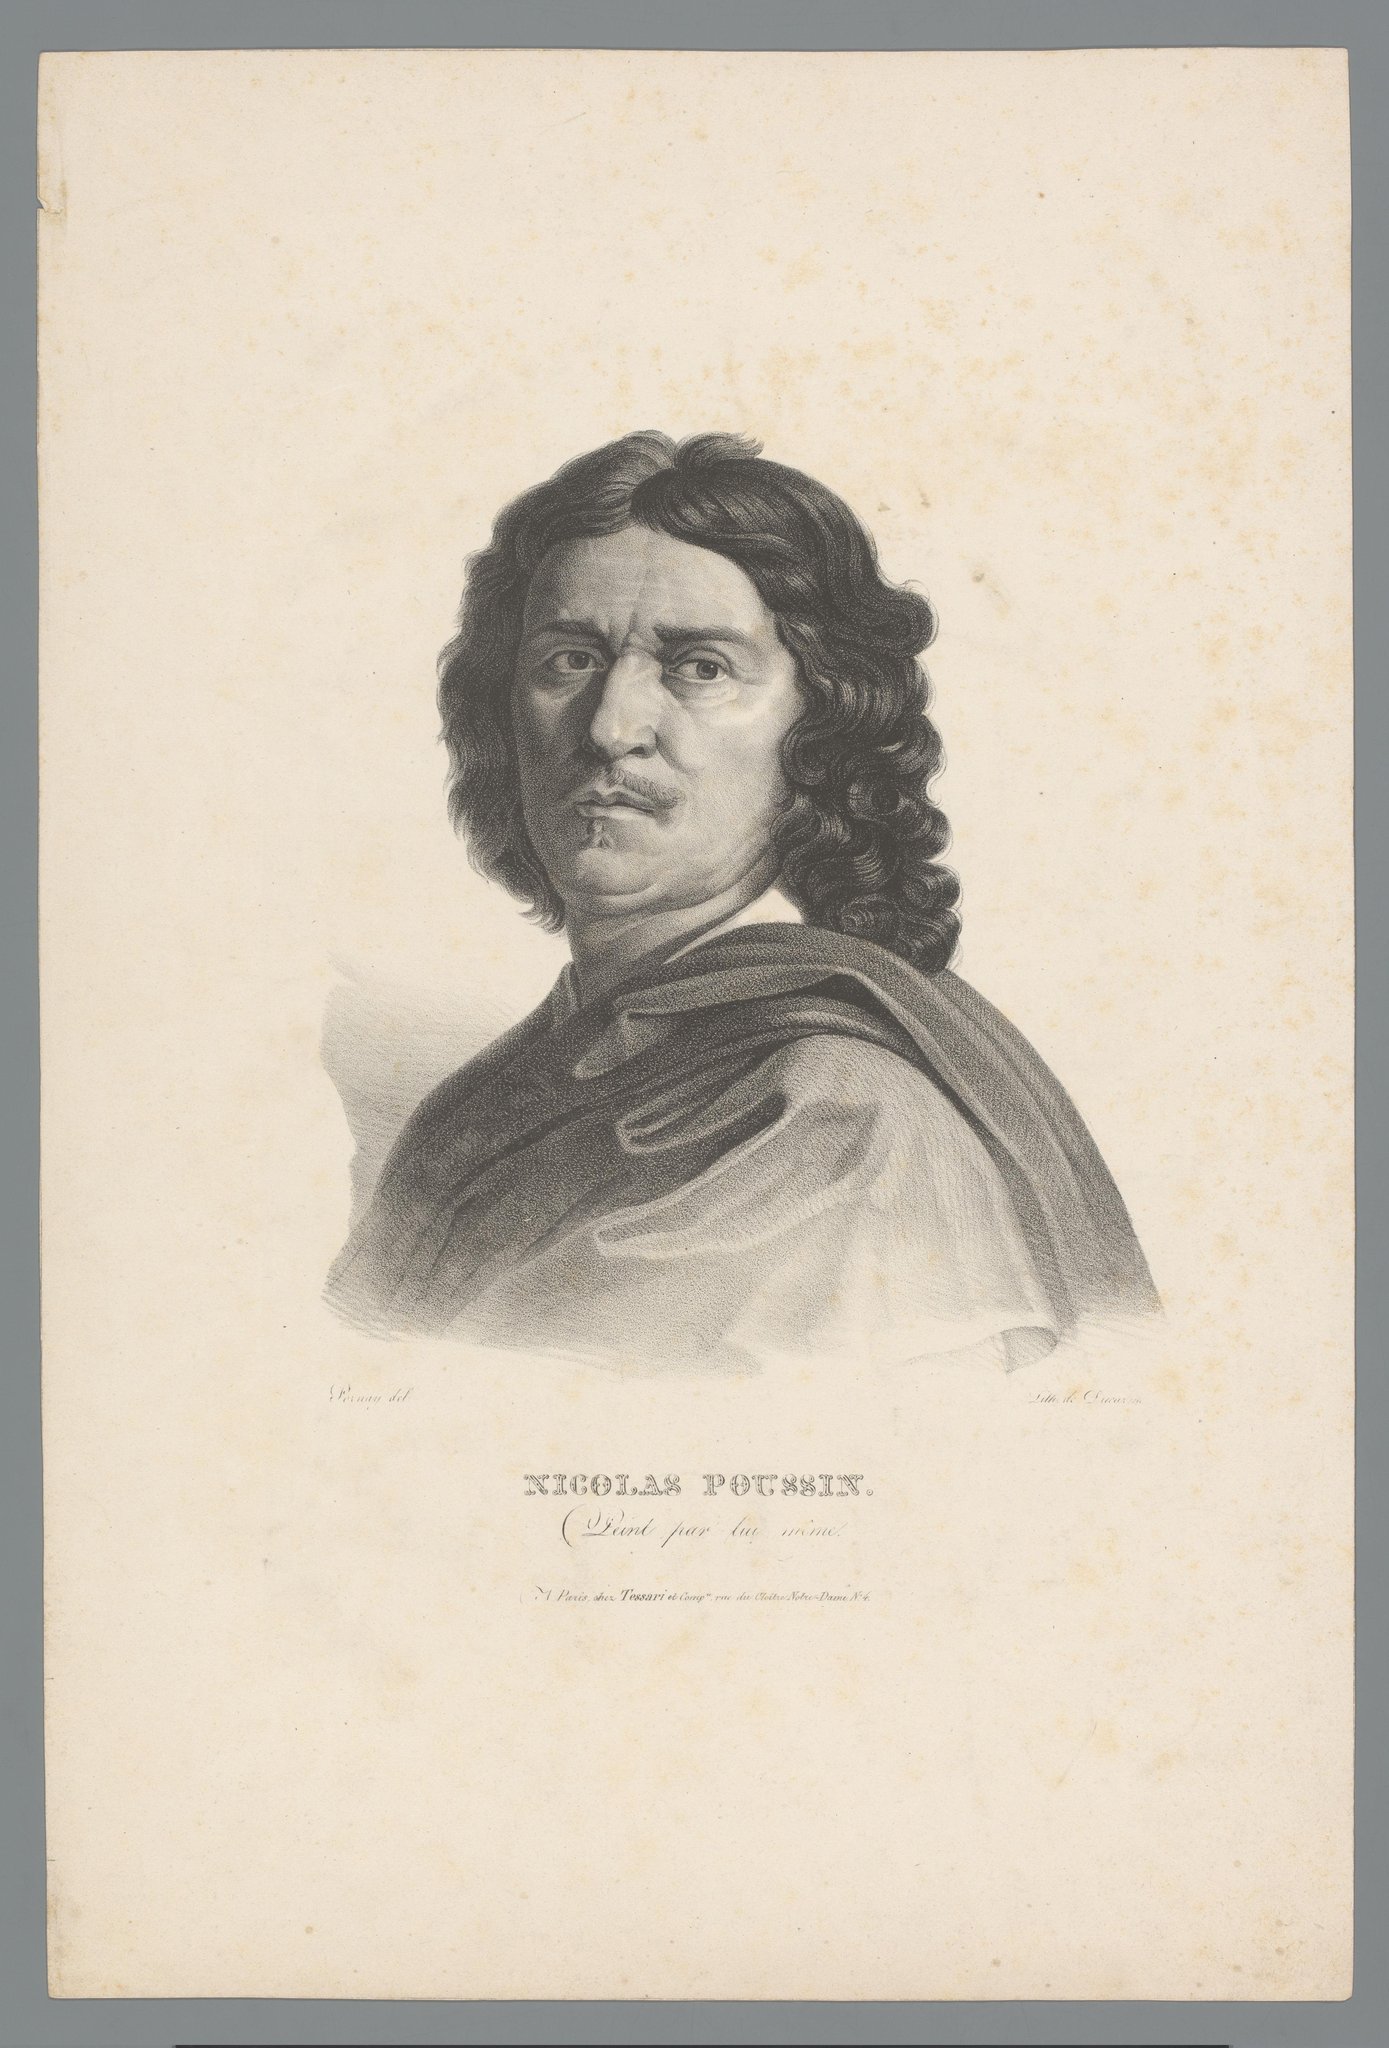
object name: print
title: Portret van schilder Nicolas Poussin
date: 1820-1829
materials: paper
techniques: lithograph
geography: paris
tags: rome, painter, draughtsman, nicolas poussin, historical persons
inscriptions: collector's mark: Lugt 2228